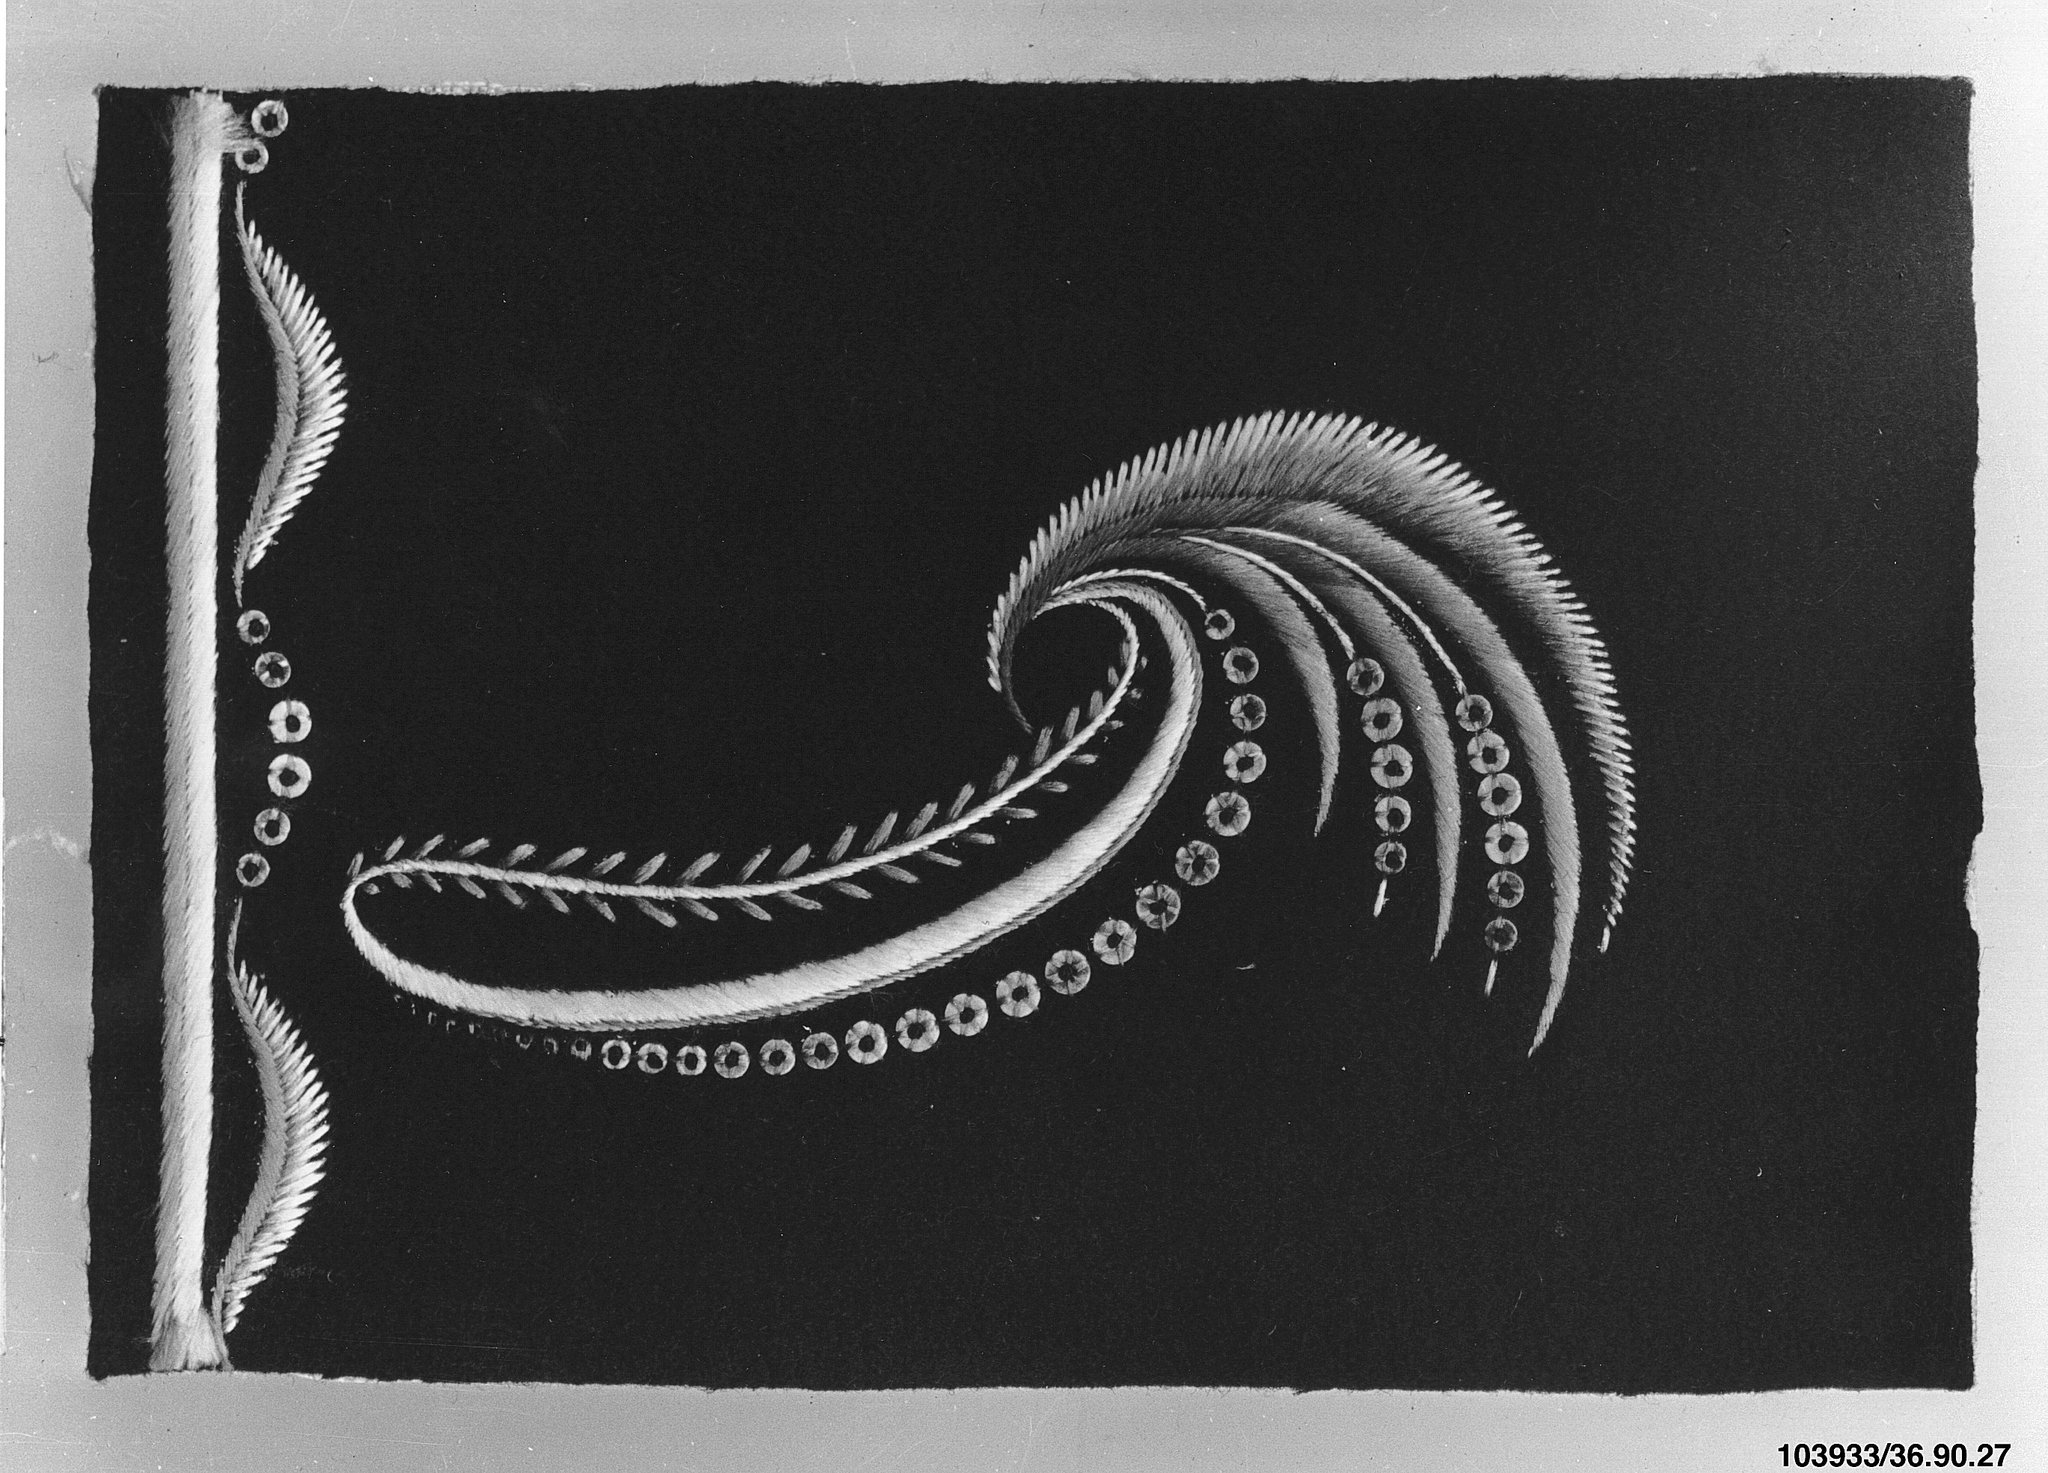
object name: sample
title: Embroidery sample for a man’s suit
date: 1785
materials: thread, wool